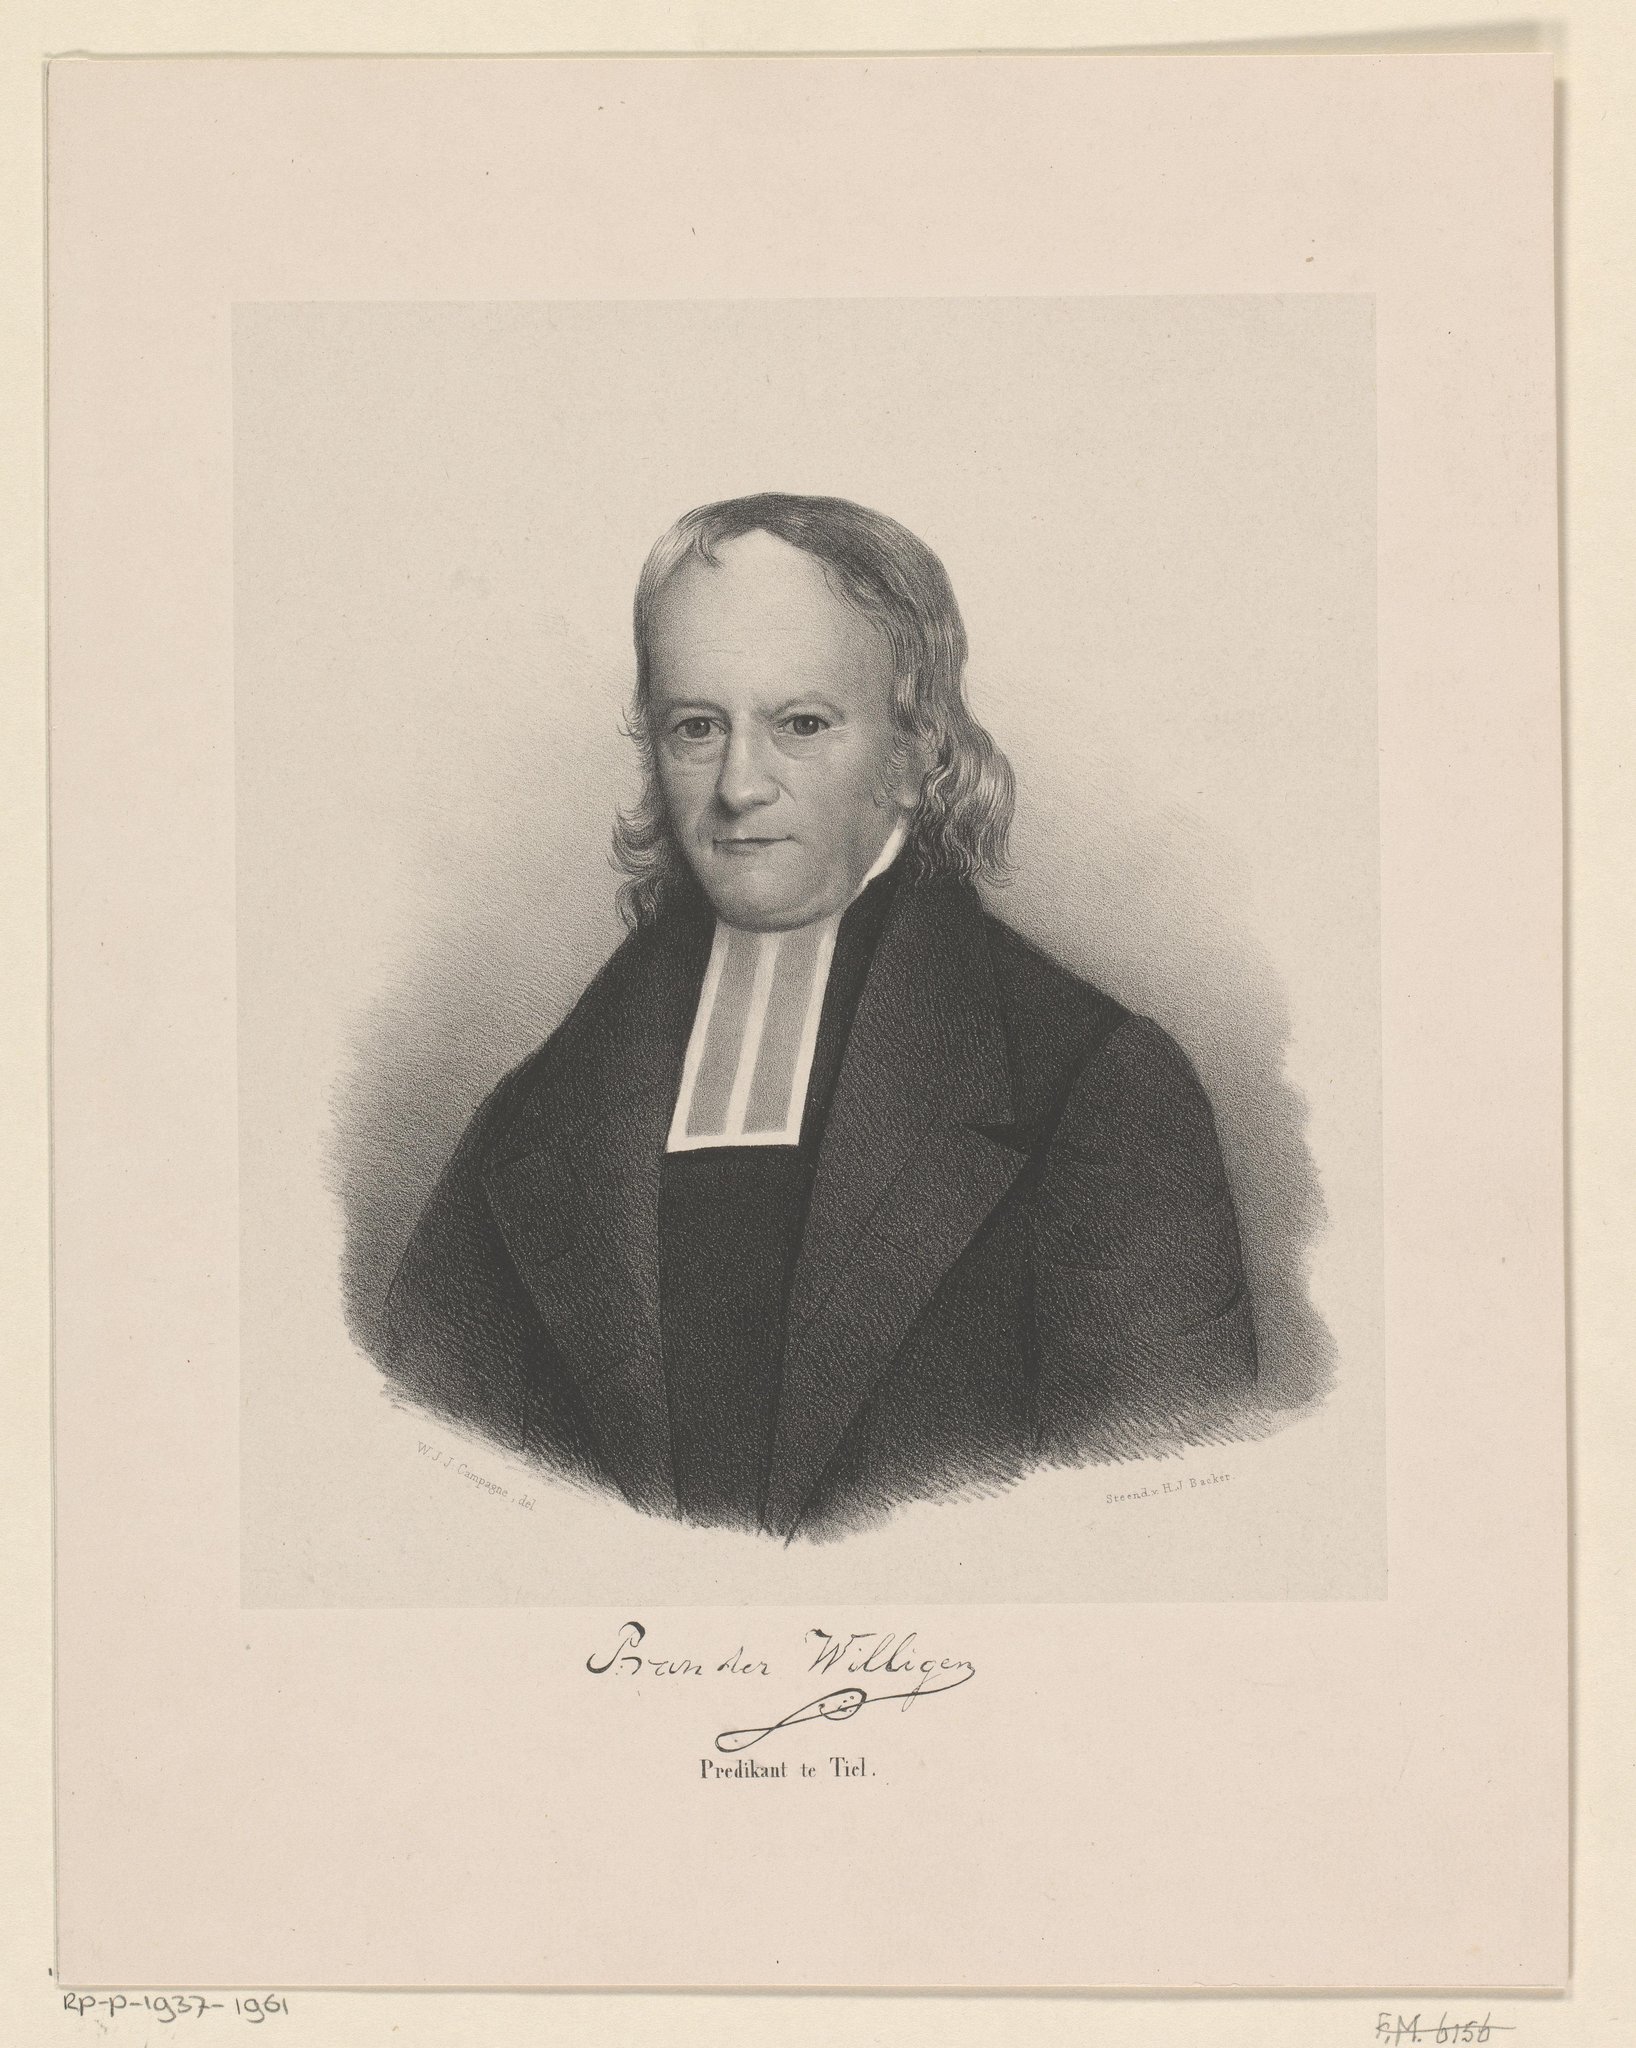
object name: print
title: Portret van Pieter van der Willigen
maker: hilmar johannes backer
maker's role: print maker, printer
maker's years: 1804-1845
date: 1822-1845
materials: paper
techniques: lithograph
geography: dordrecht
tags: rotterdam, historical persons, functionaries and dignitaries ~ protestant churches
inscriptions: collector's mark: Lugt 2760, collector's mark: Lugt 2228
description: Onder het portret de signatuur en het beroep van de geportretteerde.